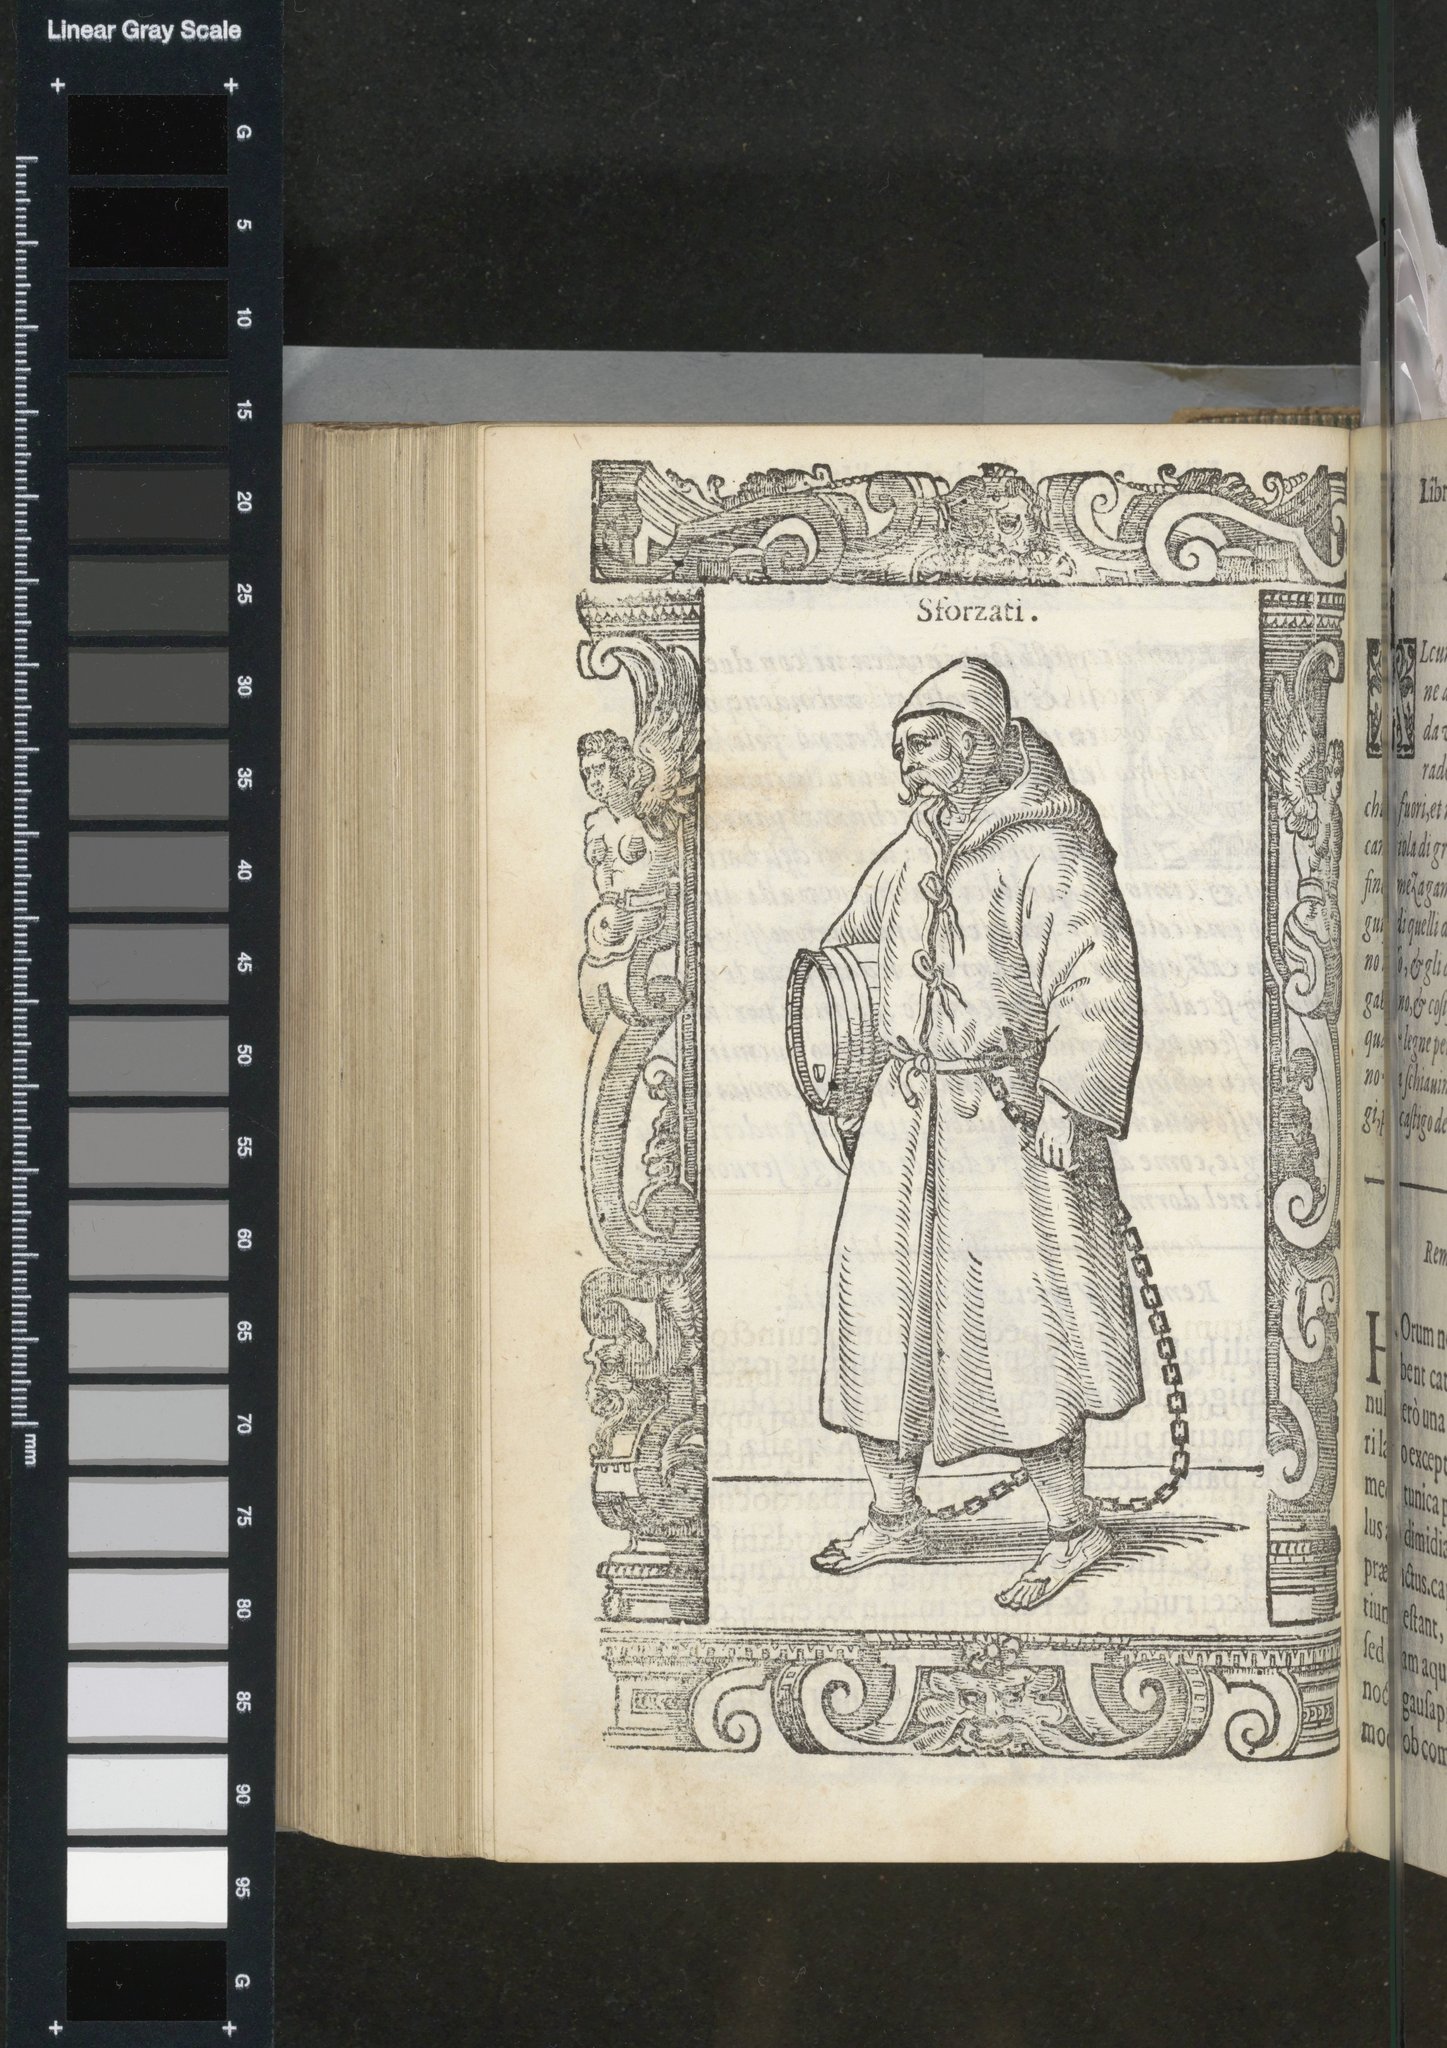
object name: costume print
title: Sforzati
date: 1598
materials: paper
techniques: woodcut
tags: fashion plates